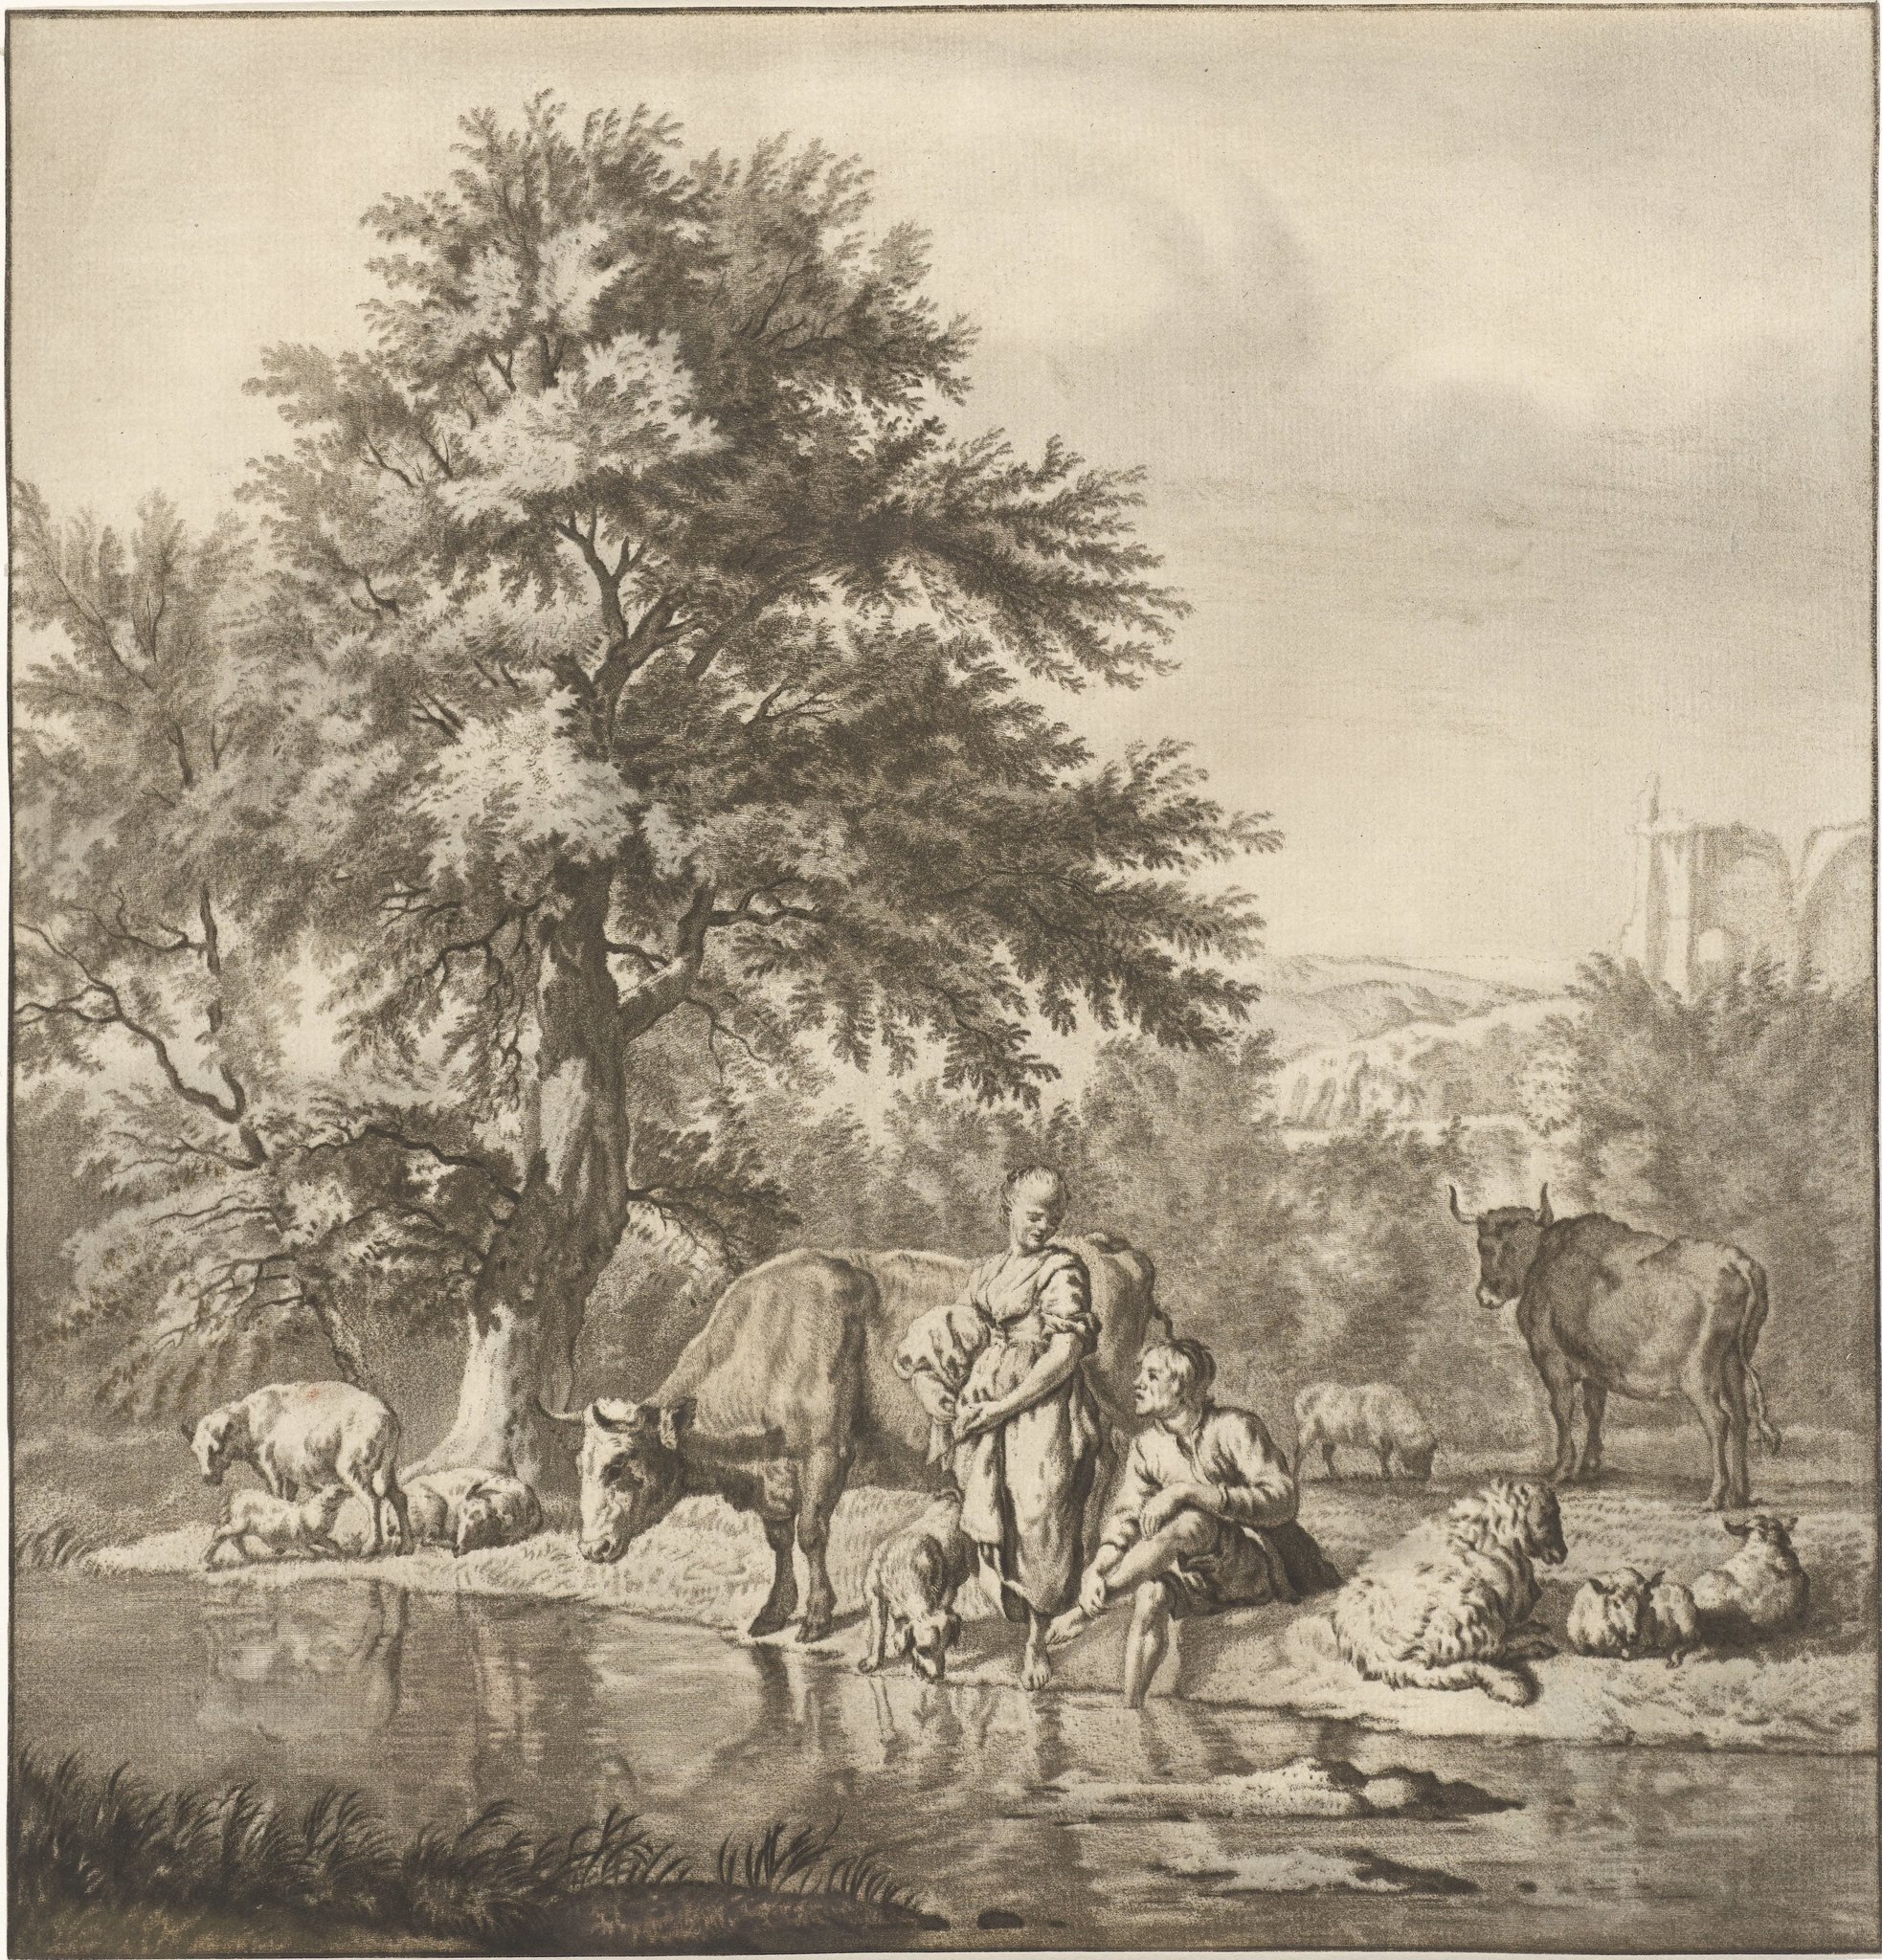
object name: print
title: Herder en herderin met kudde bij een rivier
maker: cornelis ploos van amstel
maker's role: draughtsman, print maker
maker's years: 1726-1798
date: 1763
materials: paper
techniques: printmaking, etching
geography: amsterdam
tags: cow, herding, herdsman, herdswoman, shepherd, shepherdess, cowherd, etc., sheep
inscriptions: collector's mark: Lugt 2725, inscription: ‘Ad. vd. Velde del. Ploos van Amstel. Fecit. 1763.’, collector's mark: Lugt 240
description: Een herder en een herderin staan op de oever van een rivier met hun schapen en koeien.